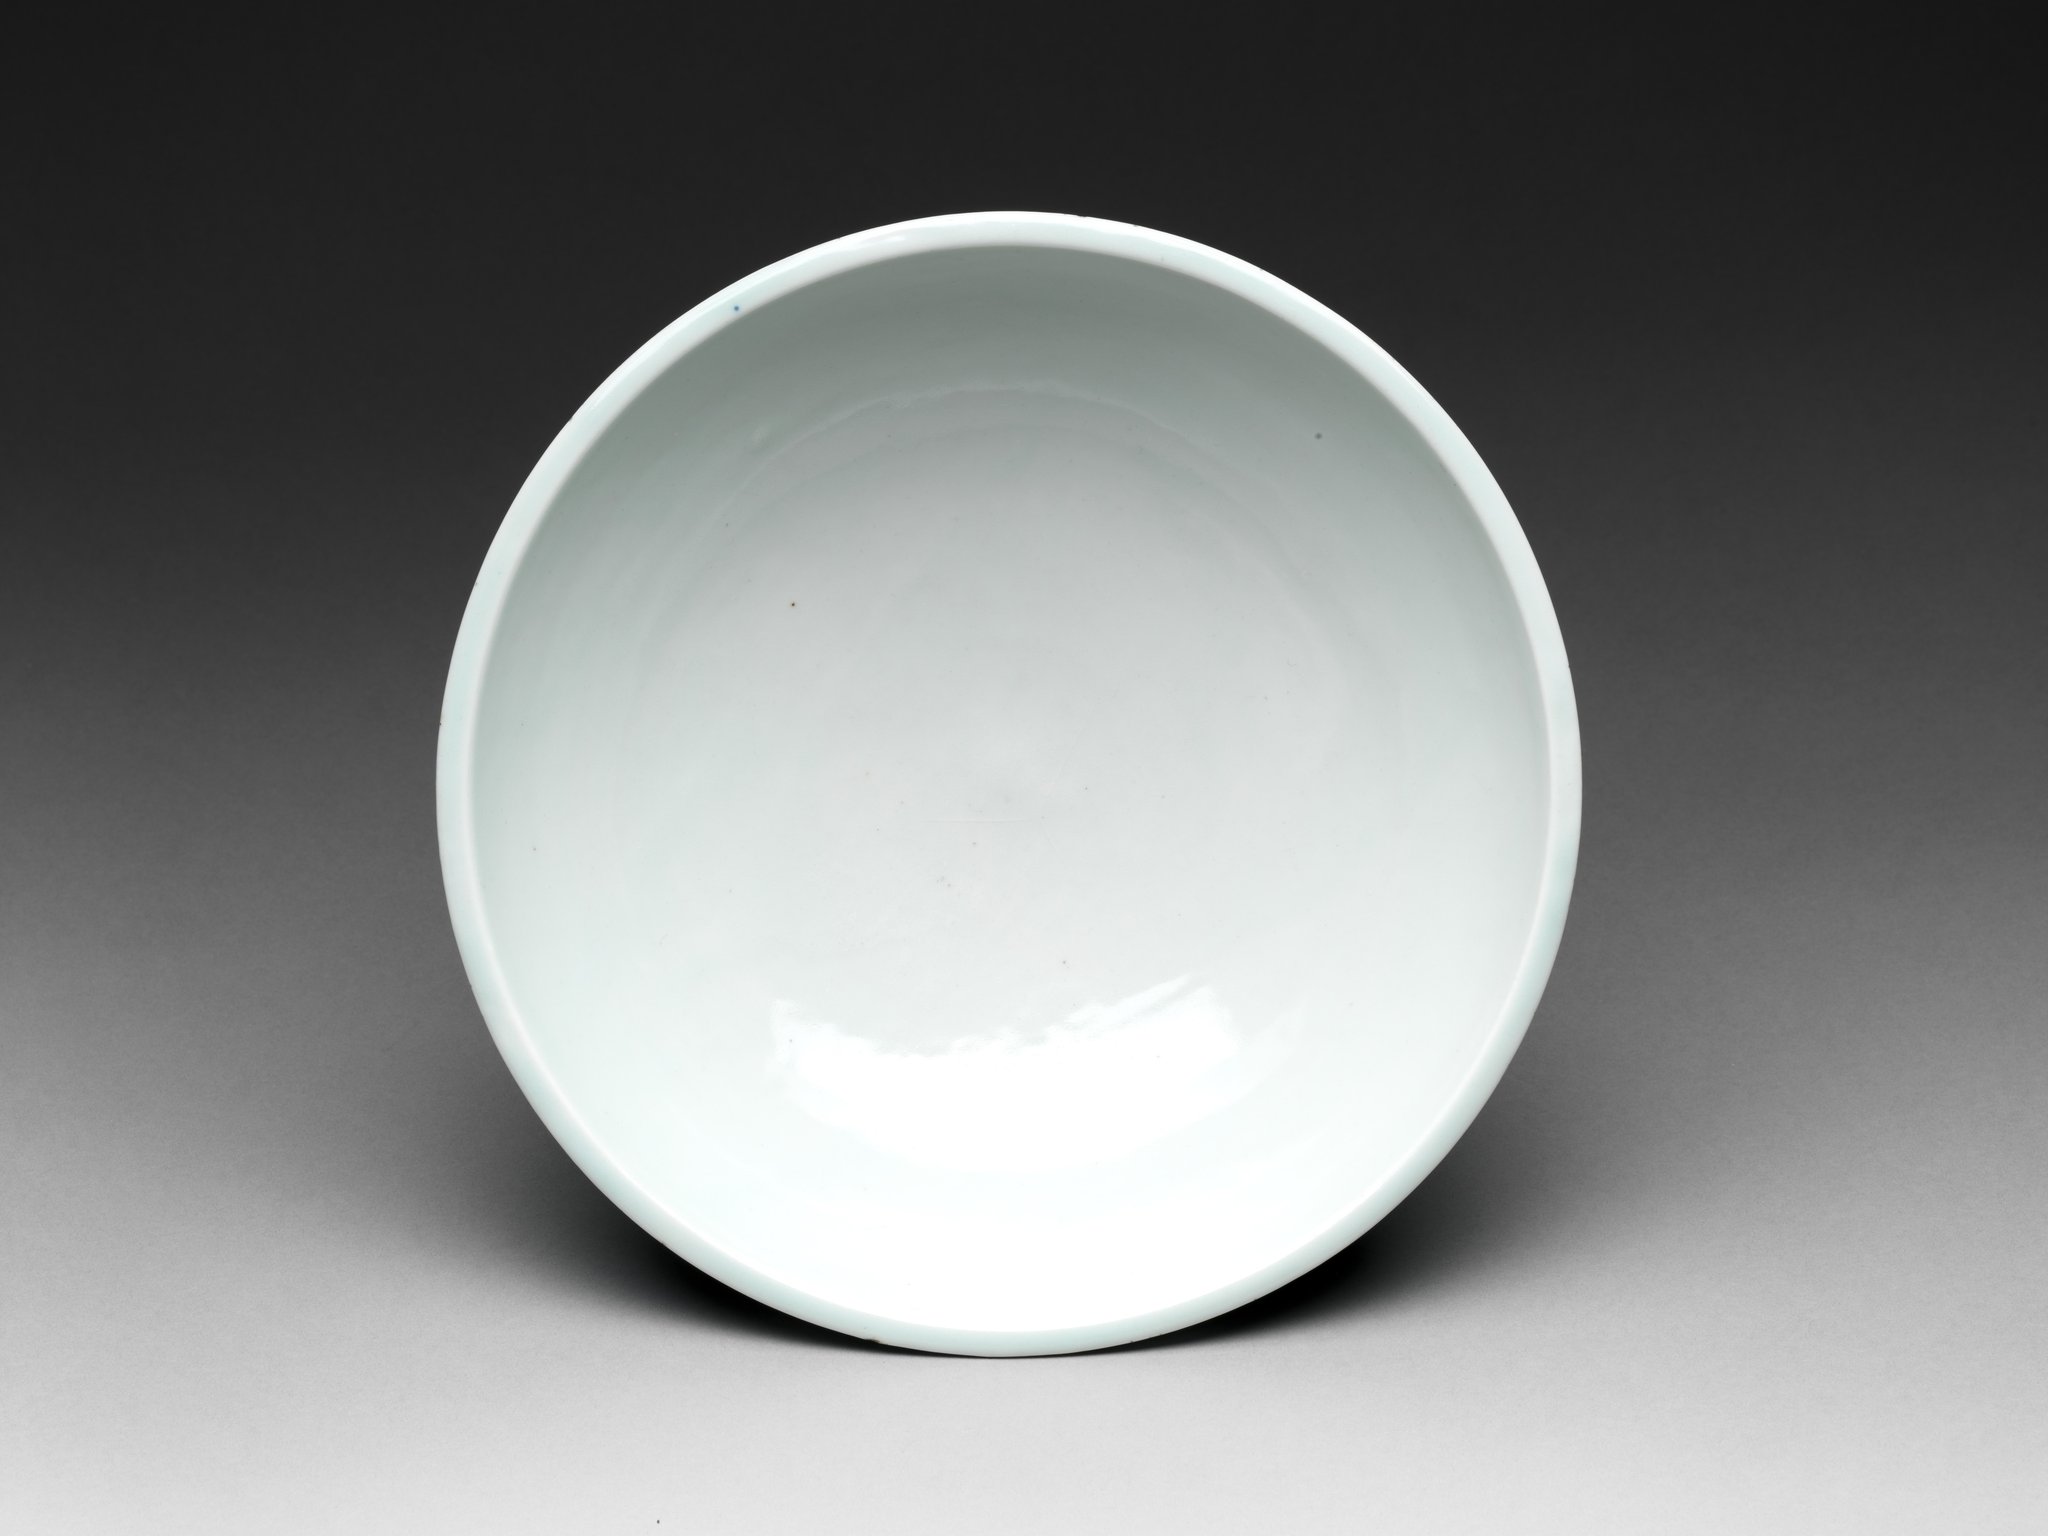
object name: bowl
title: Bowl with Peonies, Narcissus, and Pomegranates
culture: chinese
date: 1401-1433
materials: cobalt, glaze, porcelain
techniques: painting